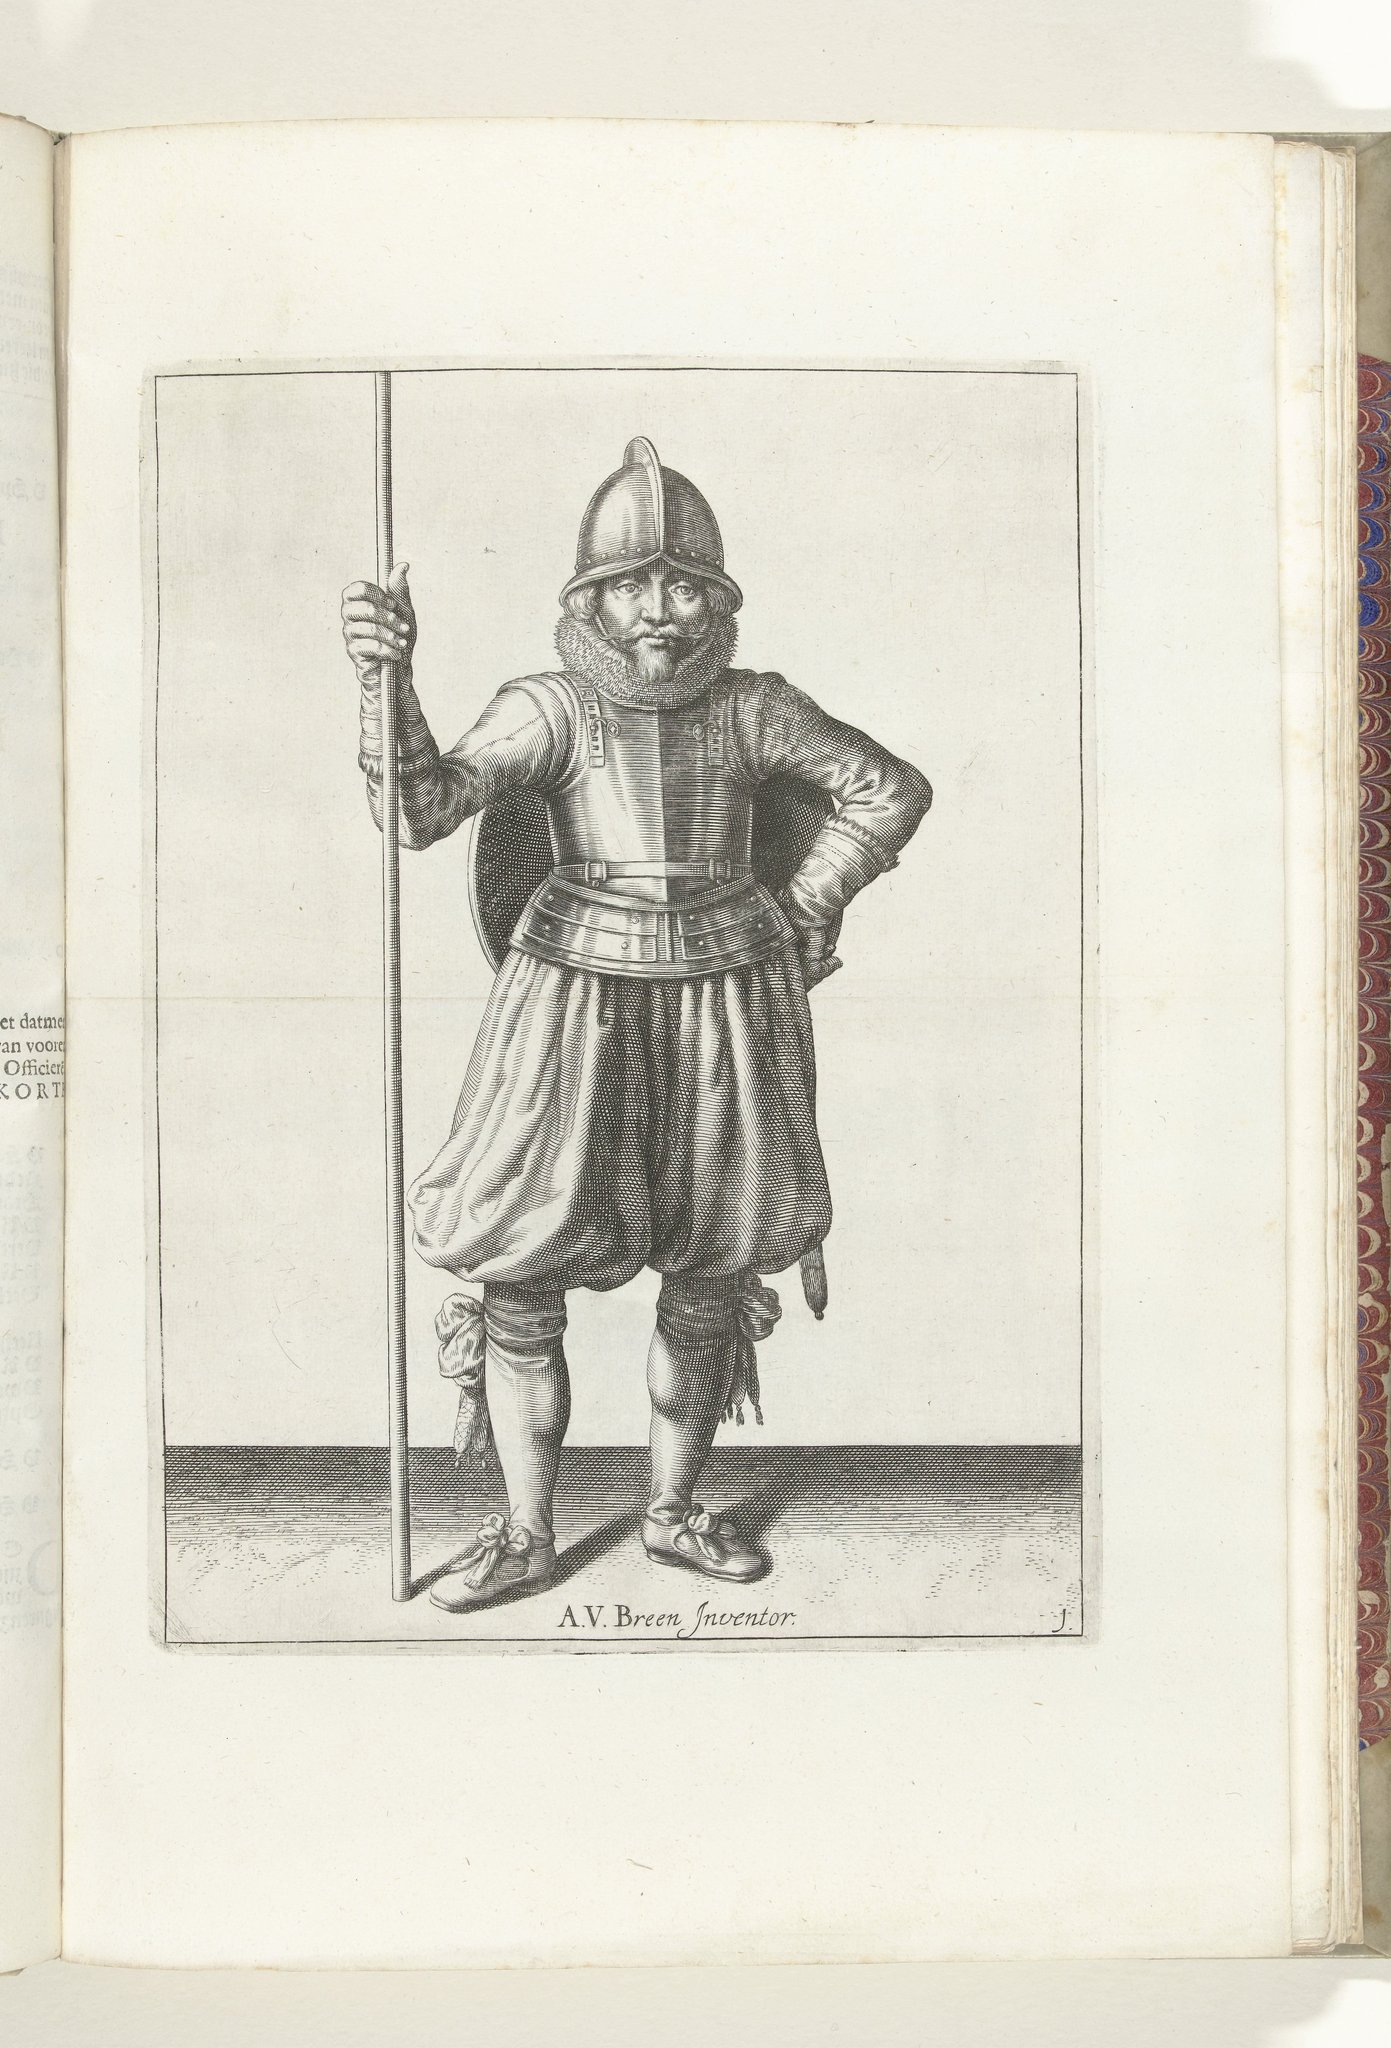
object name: print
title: De exercitie met schild en spies: de soldaat in rust met de spies in de hand en het schild op de rug (nr. 1), 1618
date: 1616-1618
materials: paper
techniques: engraving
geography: northern netherlands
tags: maurice (prince of orange), handling of weapons ~ military training, weapons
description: Illustratie in: Adam van Breen, De Nassausche Wapen-Handelinge, van Schilt, Spies, Rappier ende Targe : beyde figuerlick afgebeelt, ende gestelt na de nieu ordening [van] ... Maurits van Nassau, 's-Gravenhage, [Aert Meuris] 1618, plaat nr. 1. In het exemplaar in de collectie van de Rijksmuseum Research Library (326 F 22).